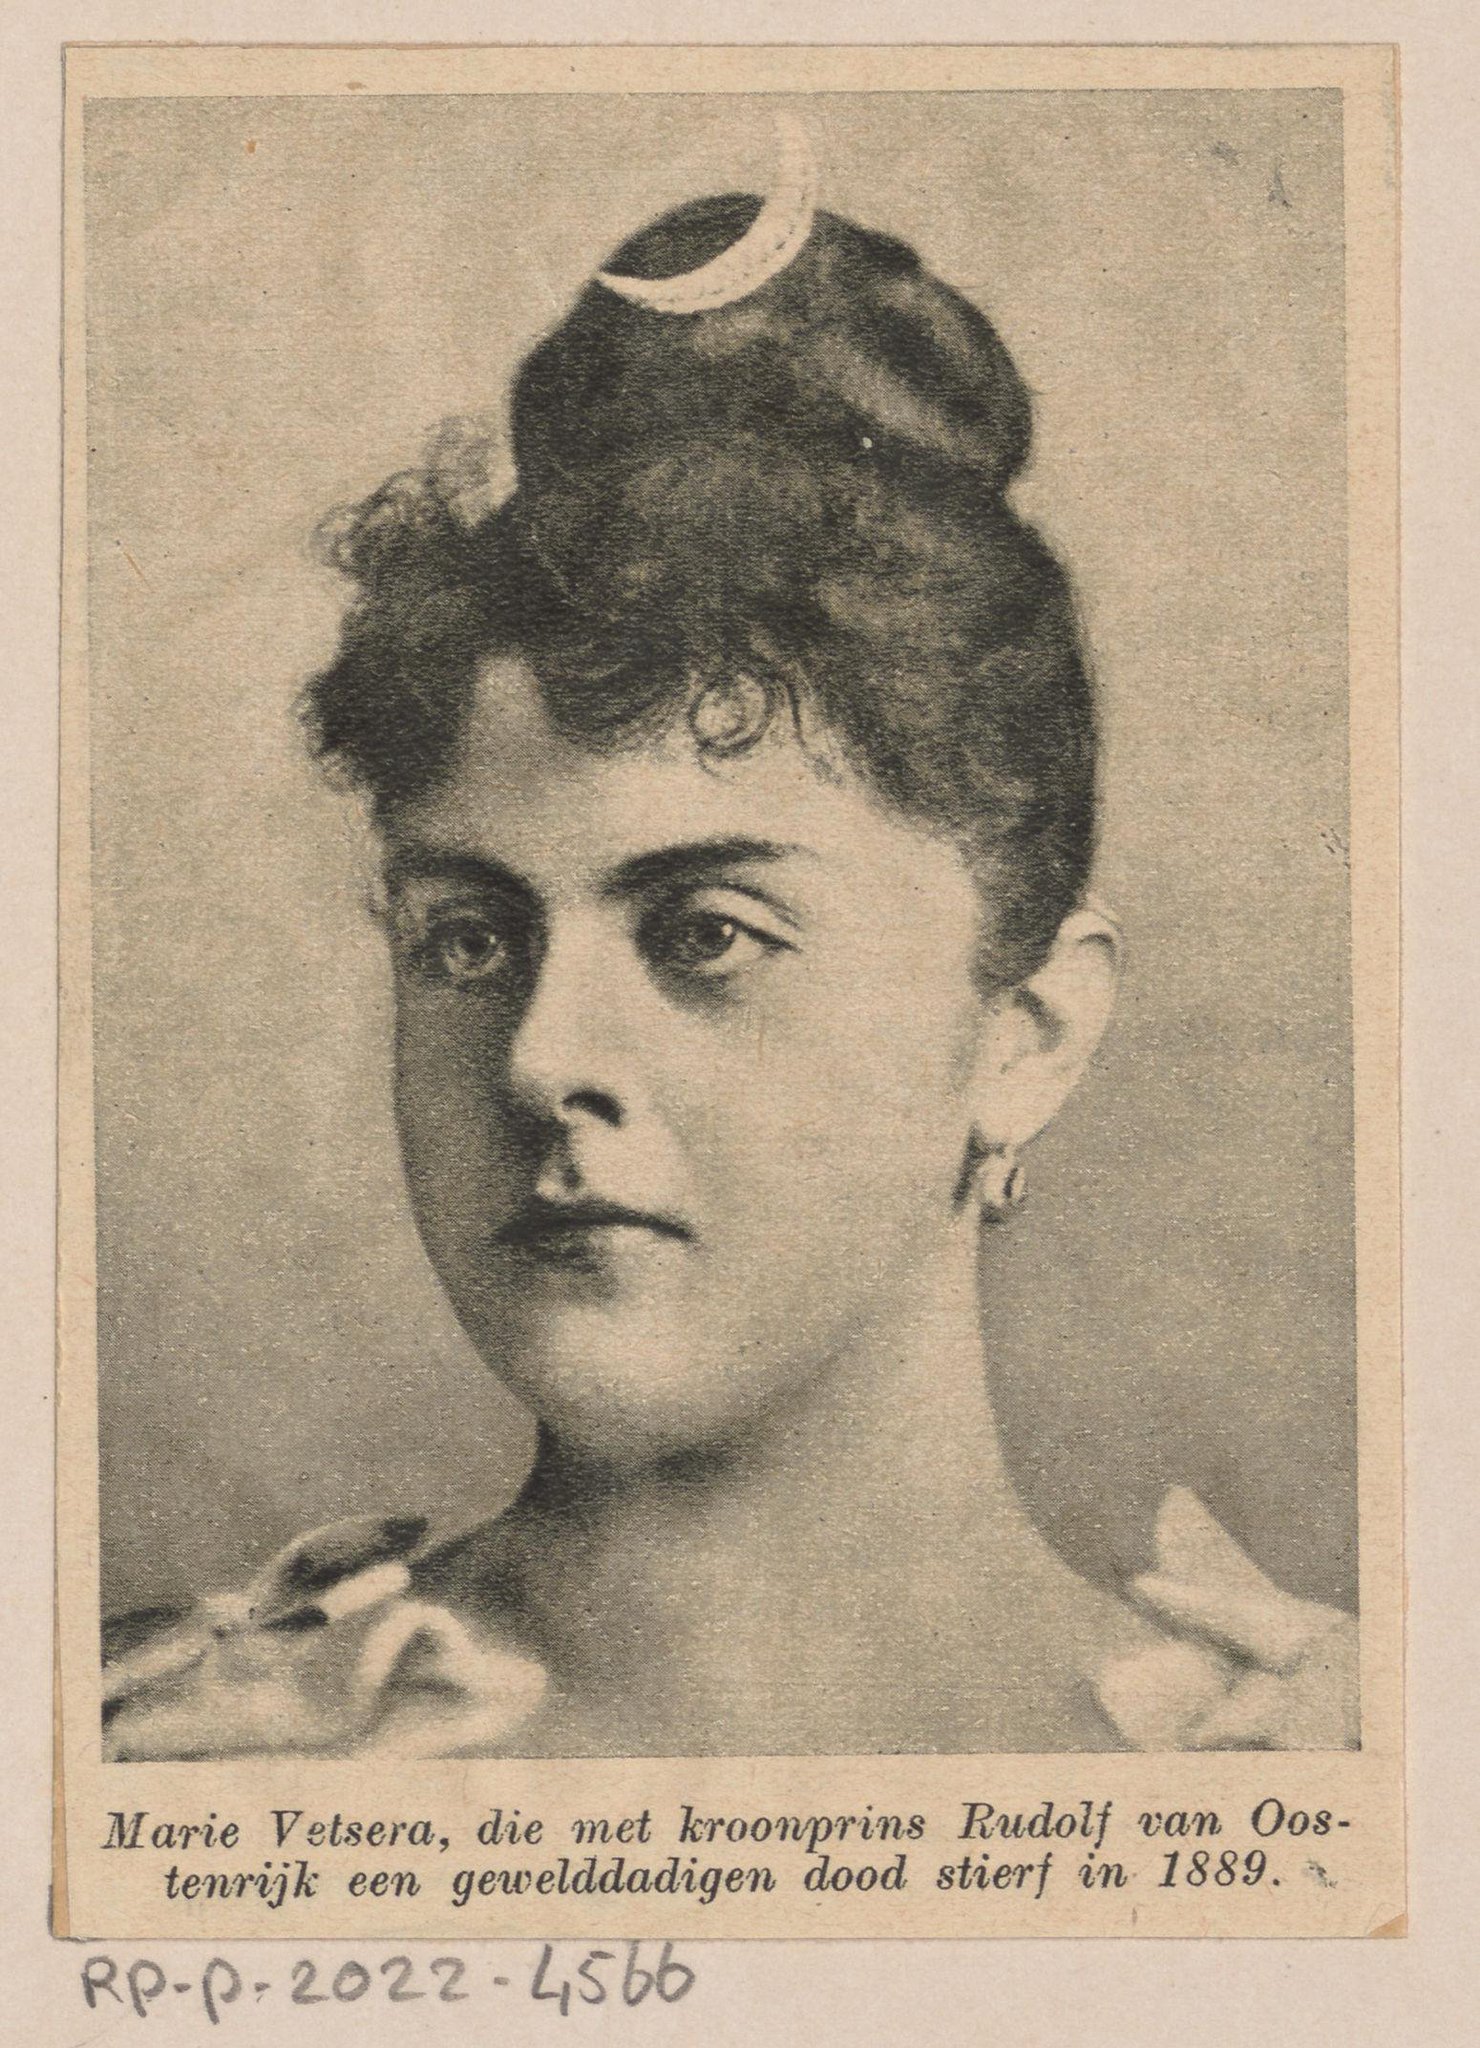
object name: photomechanical print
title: Portret van Marie von Vetsera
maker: Anonymous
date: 1889-1950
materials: paper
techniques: photochemical processes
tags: vienna, historical persons - bb - woman